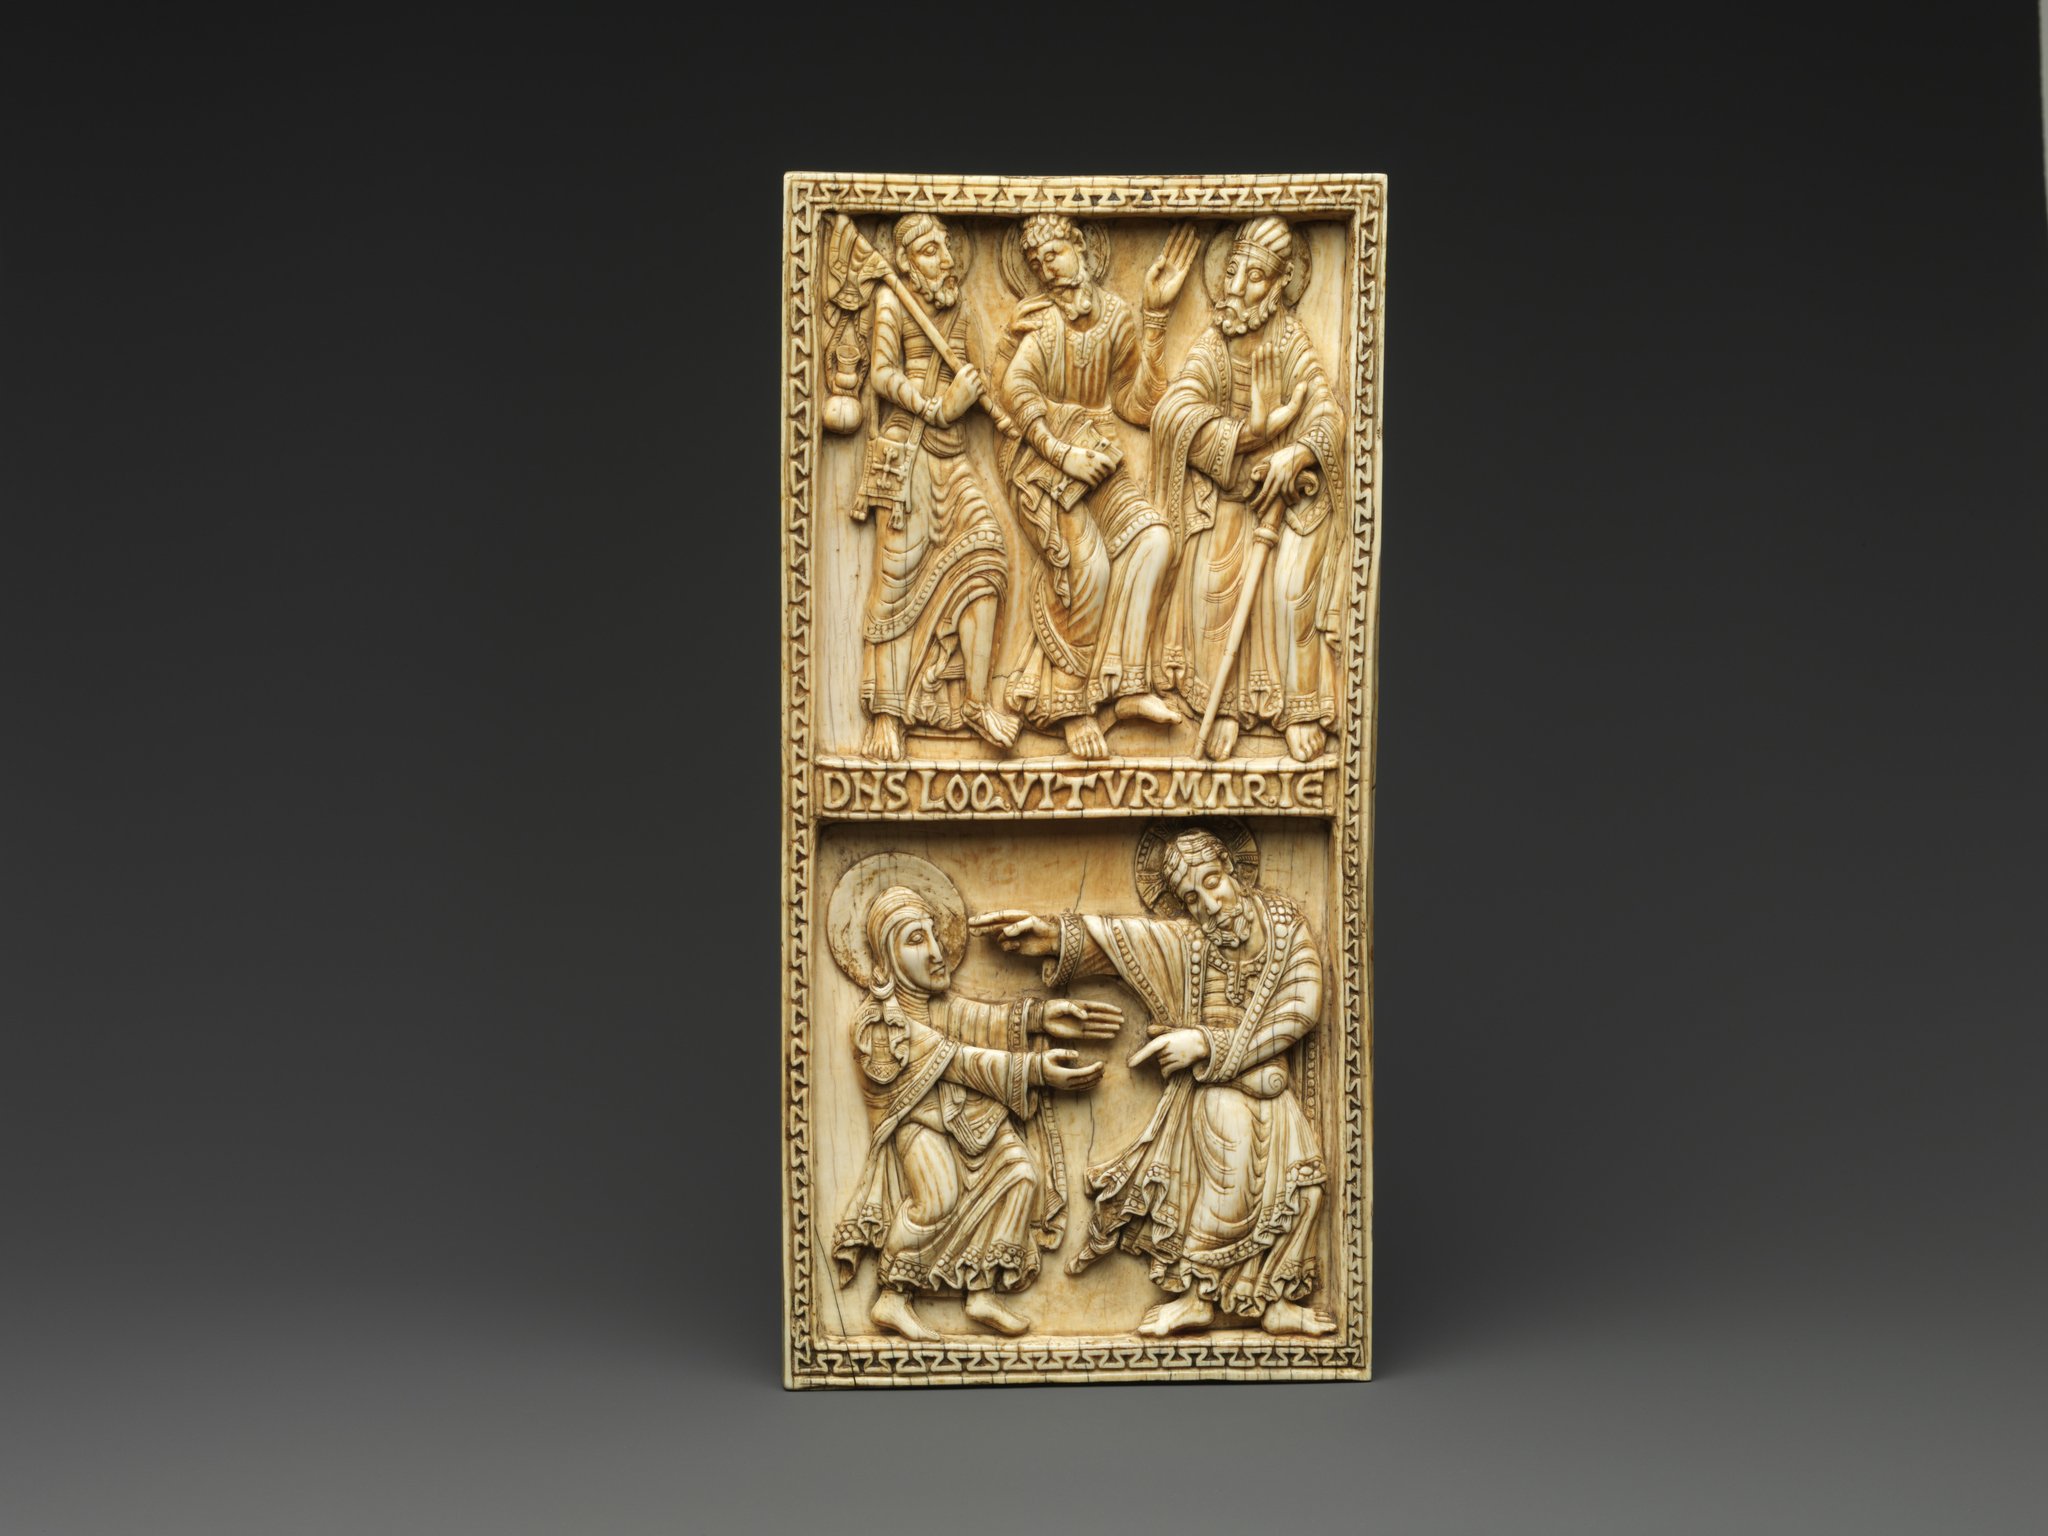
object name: plaque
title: Plaque with the Journey to Emmaus and Noli Me Tangere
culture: spanish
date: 1115-1120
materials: ivory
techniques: gilding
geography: spain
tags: men,christ,mary magdalene